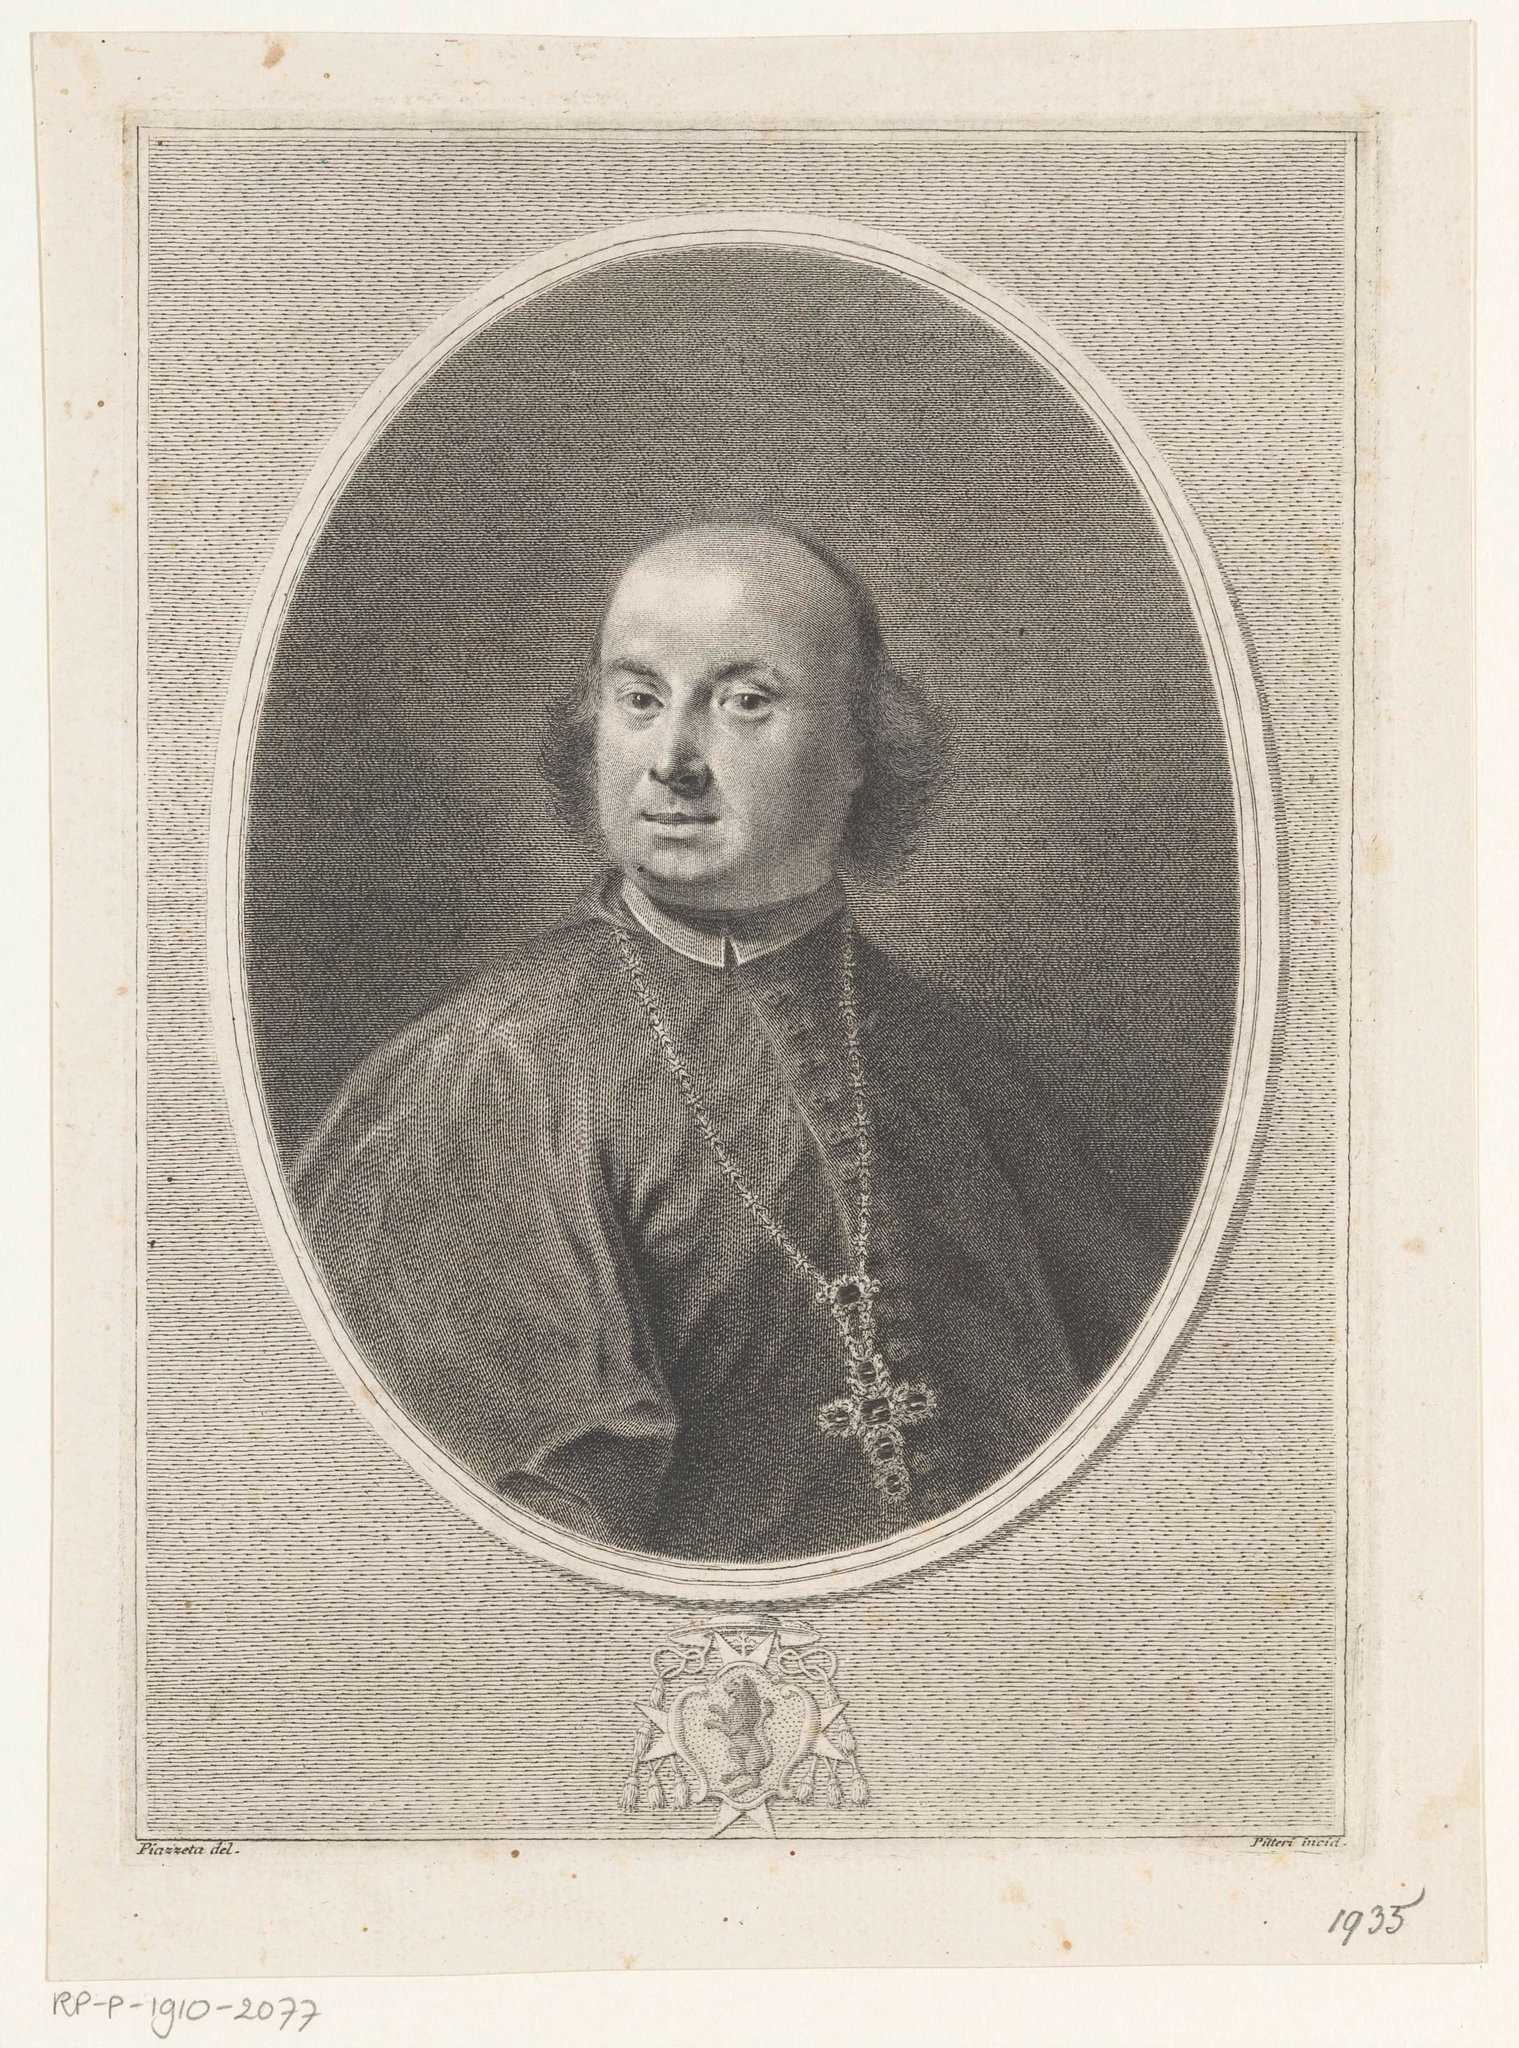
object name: print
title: Portret van een kardinaal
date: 1718-1746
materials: paper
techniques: engraving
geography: venice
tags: bari, trani, cardinal, historical persons, anonymous historical person portrayed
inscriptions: collector's mark: Lugt 2228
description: Portret van Giuseppe Antonio Davanzati. Onder het portret het wapen Davanzati